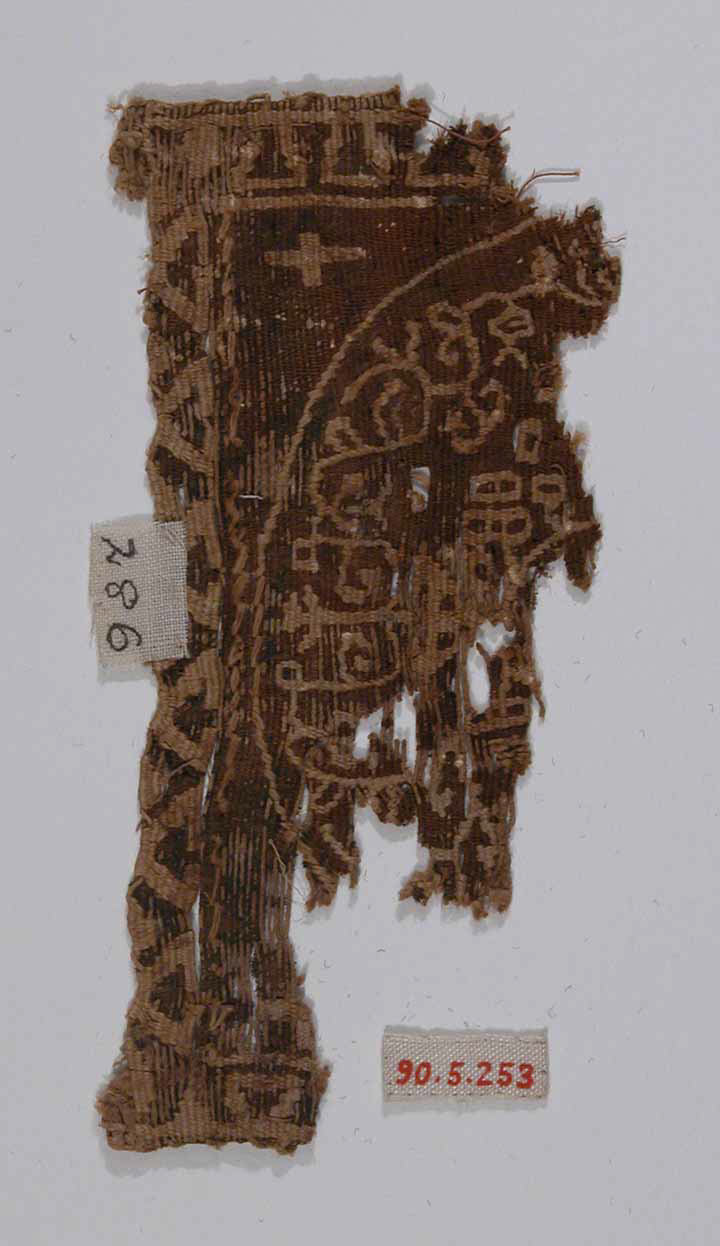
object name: textile fragment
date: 401-600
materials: linen, wool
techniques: weave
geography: egypt